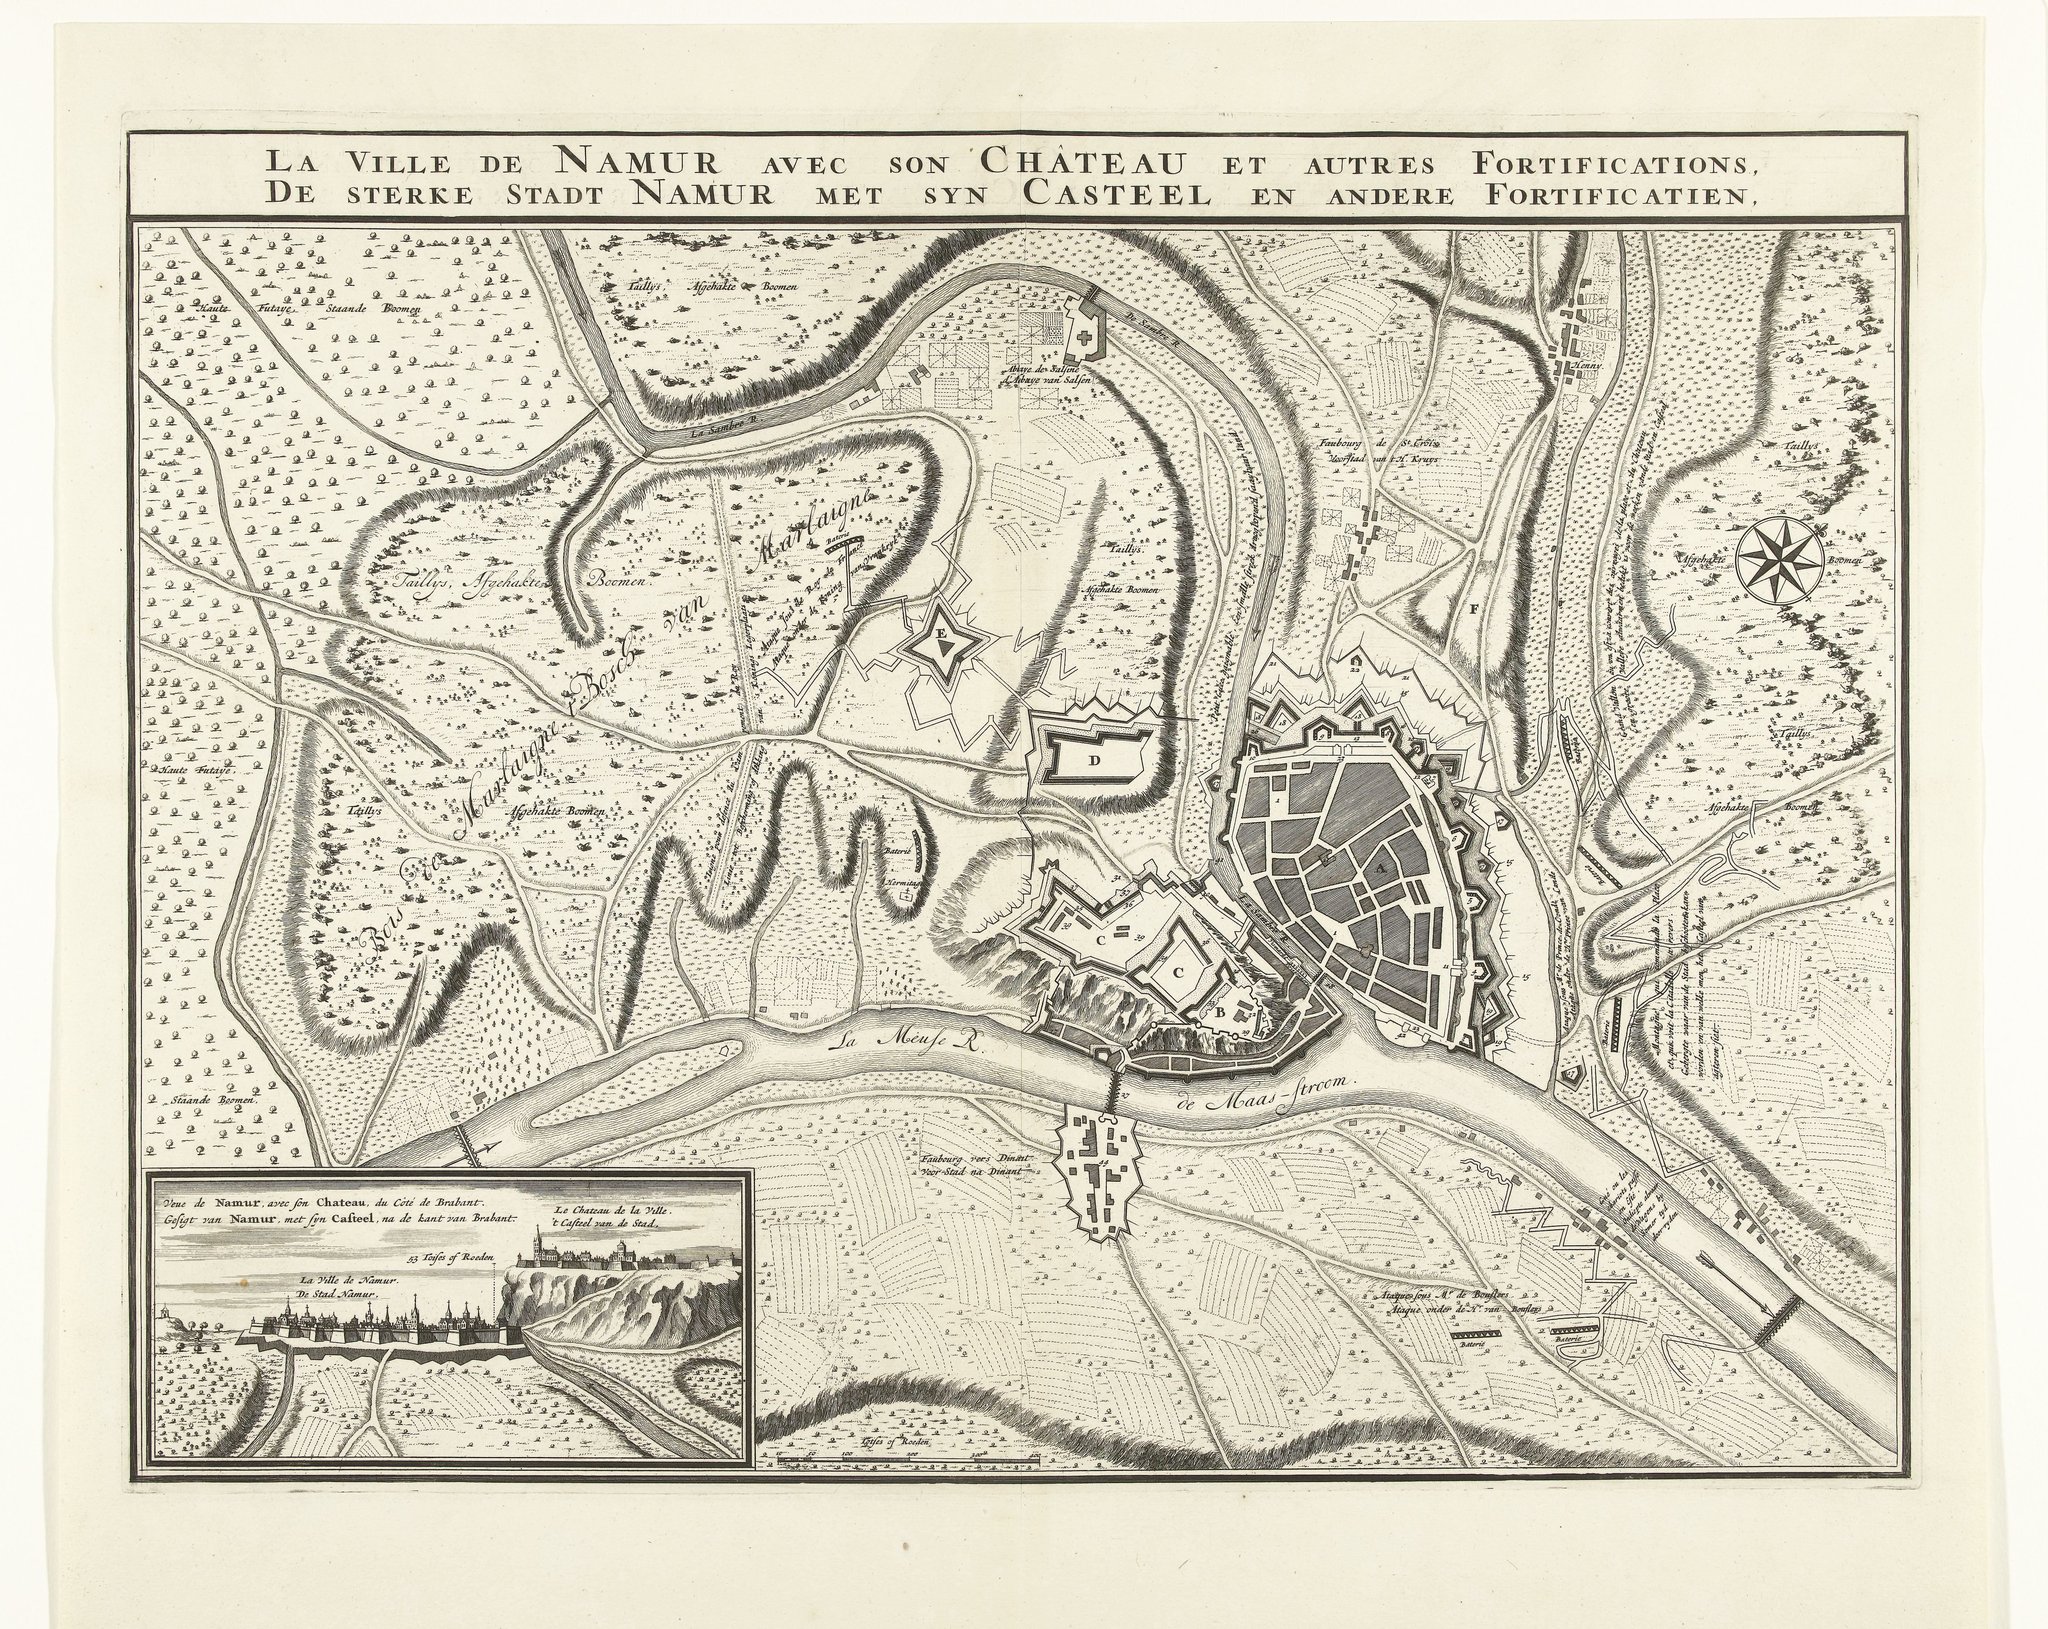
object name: print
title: Kaart van de stad Namen met het kasteel, belegerd door het Franse leger, 1692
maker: nicolaes visscher (ii)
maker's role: publisher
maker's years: 1649-1702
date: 1692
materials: paper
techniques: etching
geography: amsterdam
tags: siege, position war, maps of cities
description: Kaart van de stad Namen met het kasteel, belegerd door het Franse leger, 25 mei - 30 juni 1692. Linksonder een inzet met een gezicht op stad en kasteel.